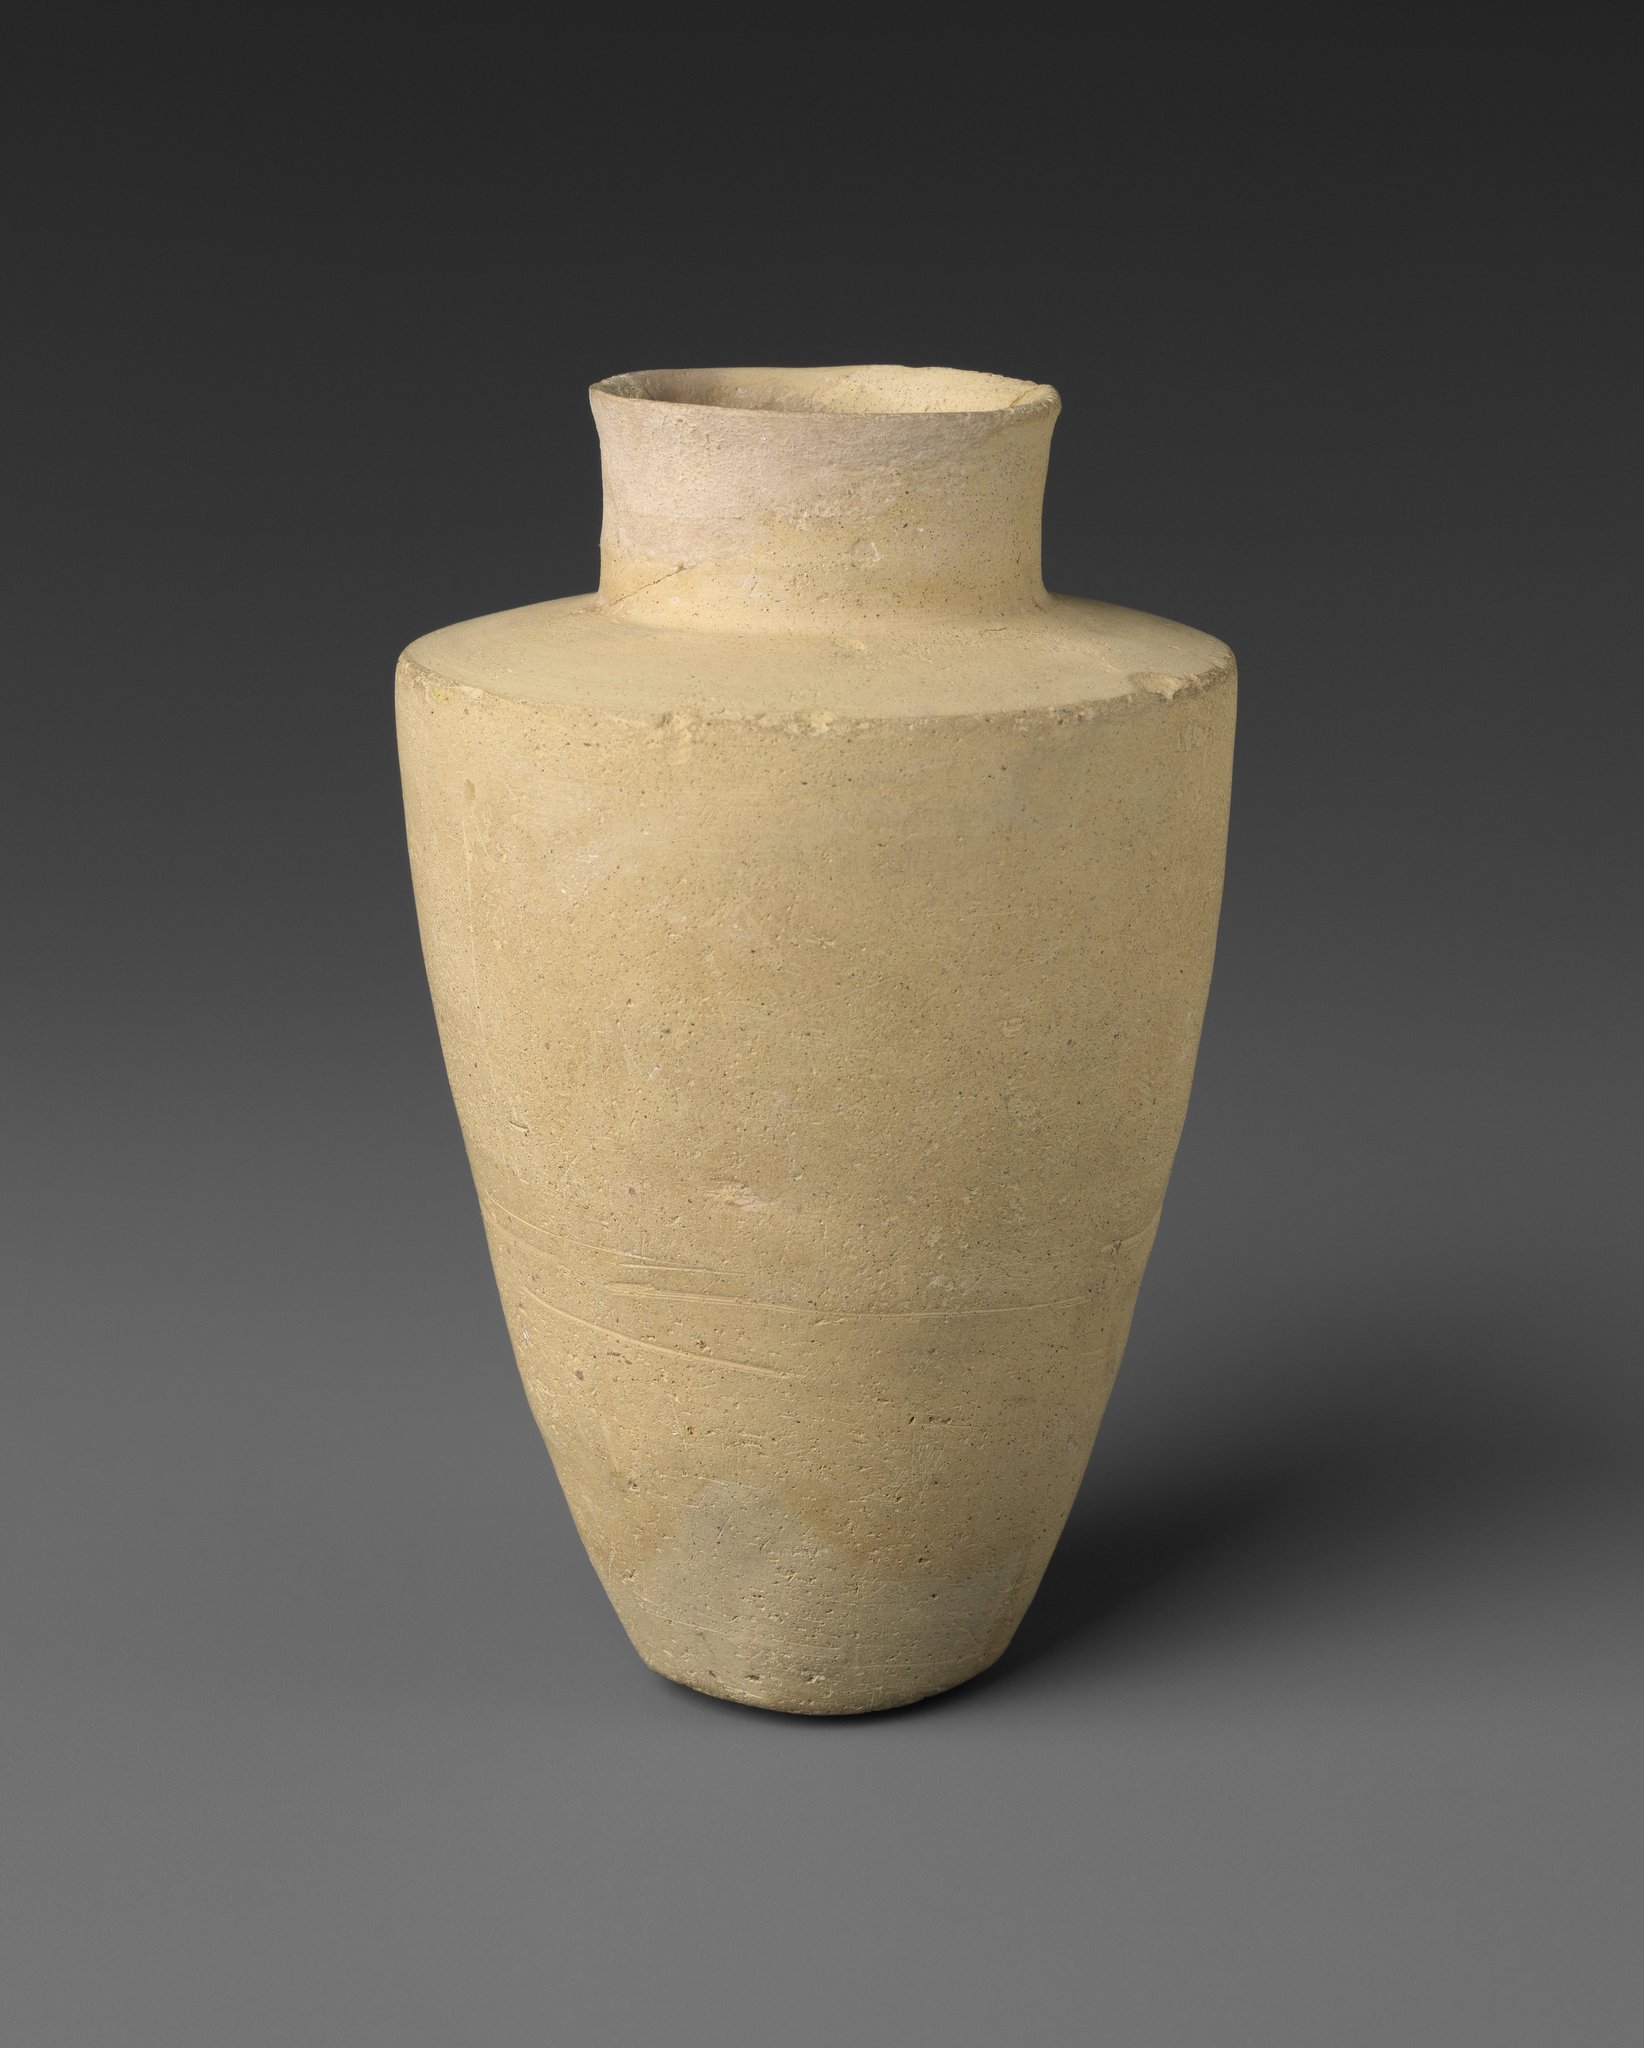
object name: jar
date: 4000-3001 BCE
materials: ceramic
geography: mesopotamia